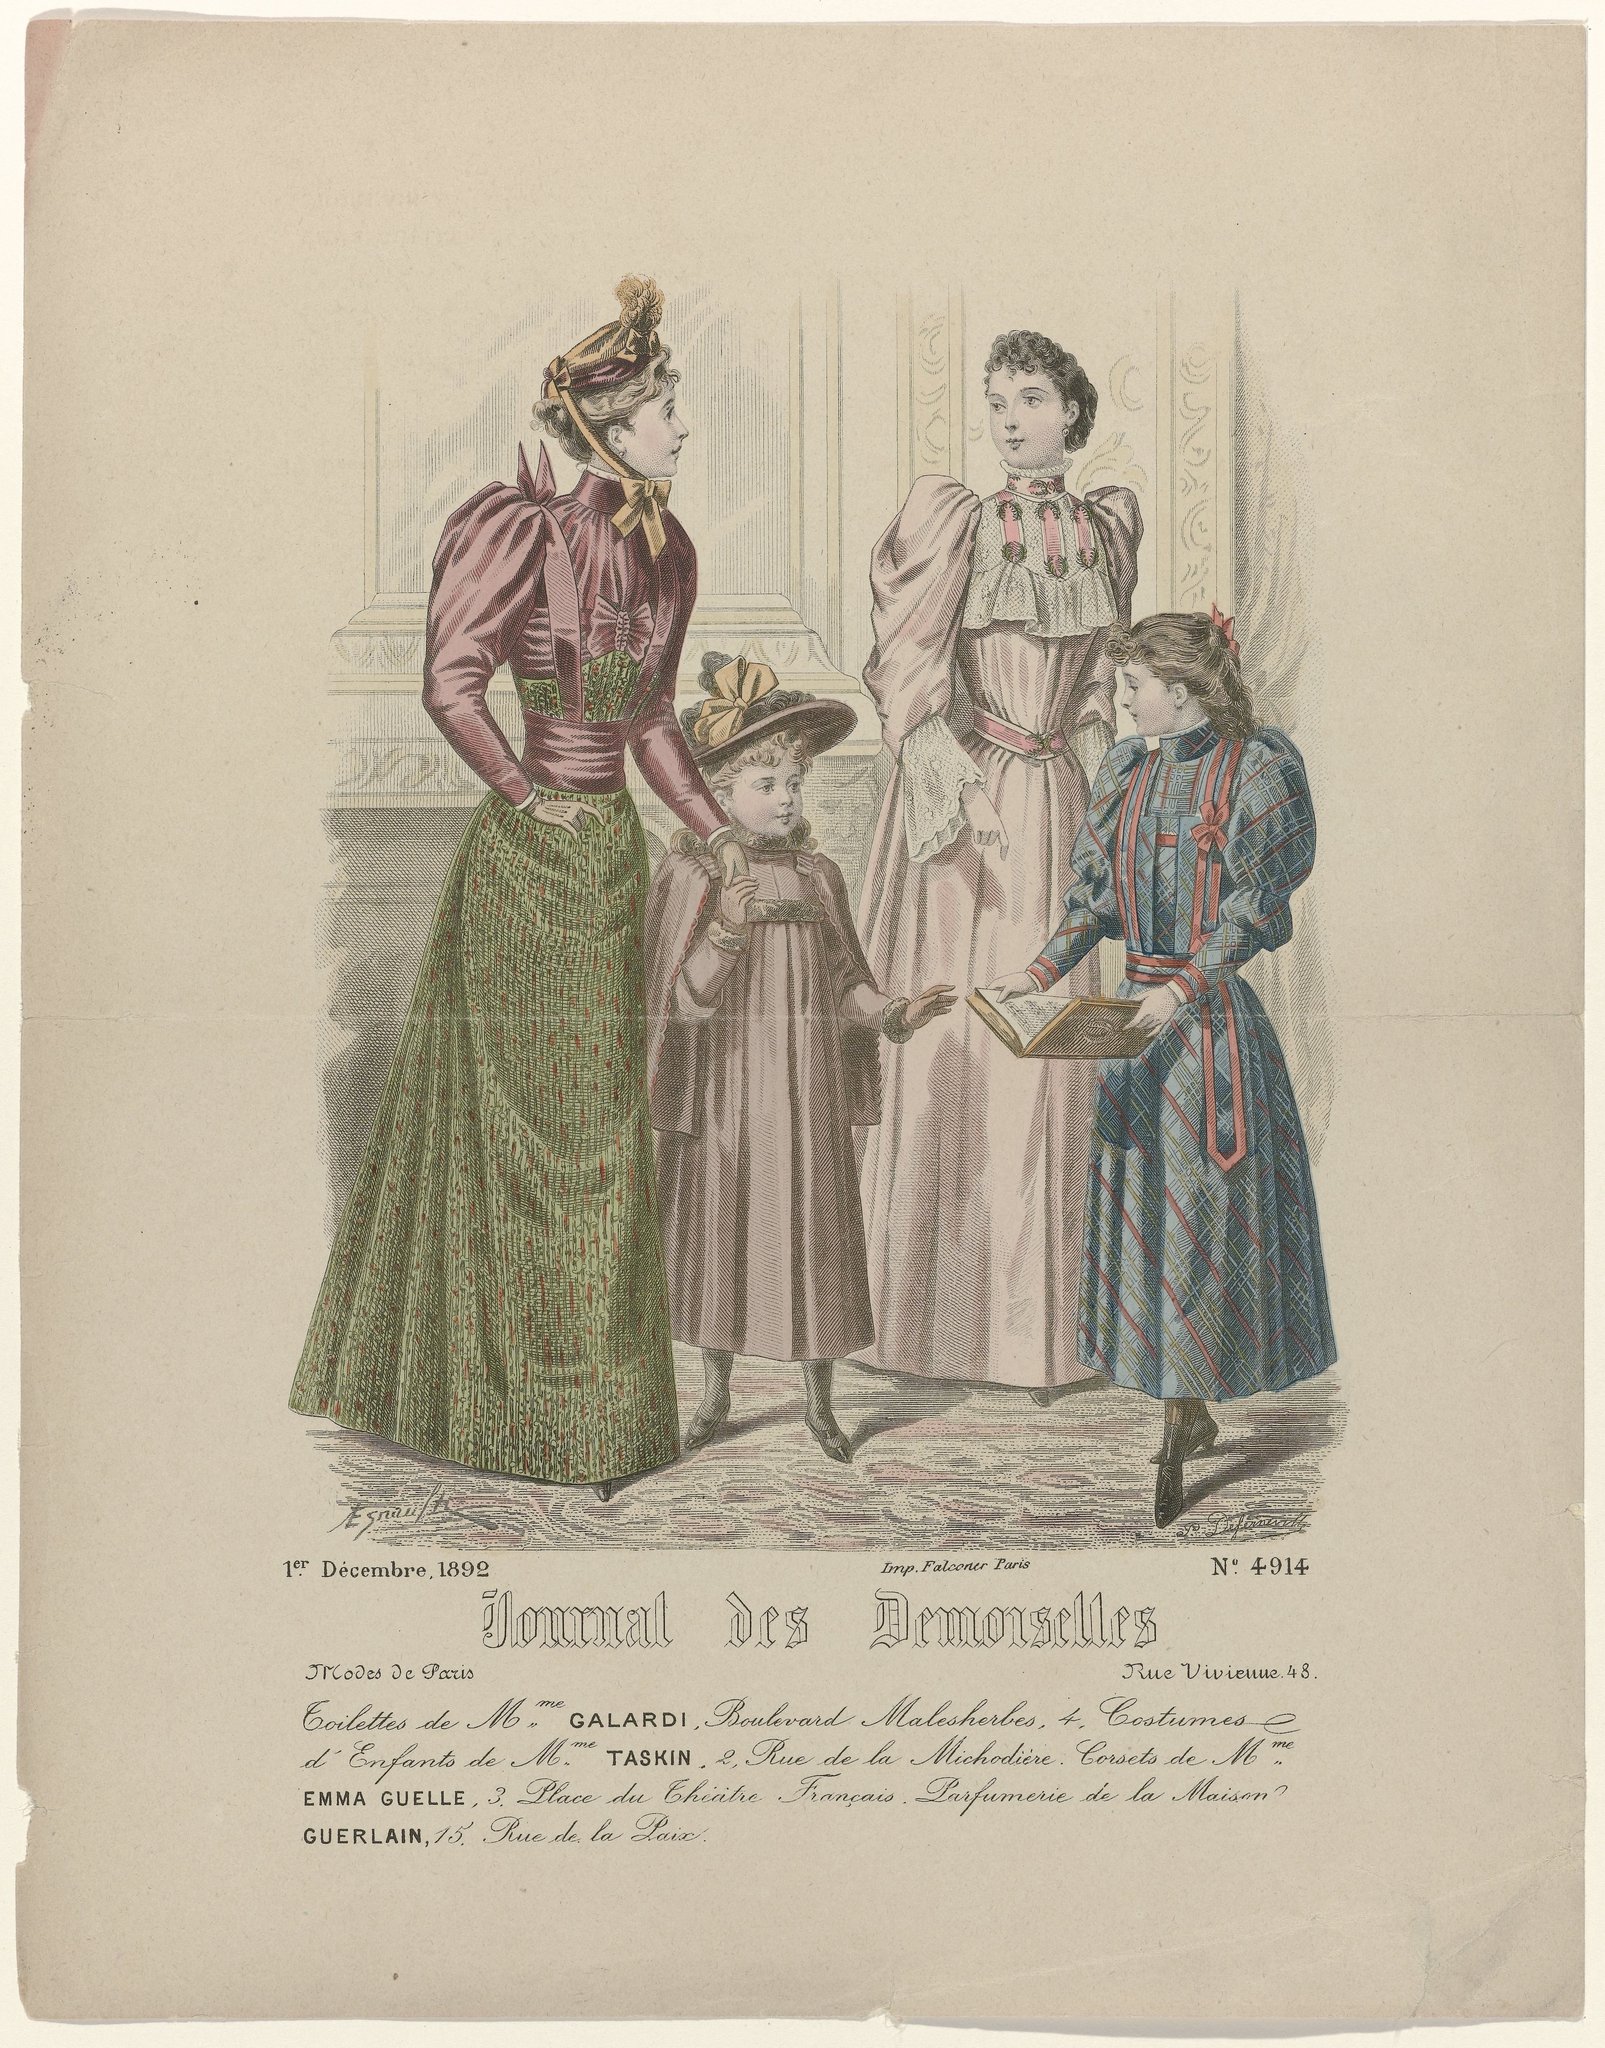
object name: fashion print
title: Journal des Demoiselles, 1 décembre 1892, No. 4914 : Toilettes de Mme Galard (...)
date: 1892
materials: paper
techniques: engraving, hand coloring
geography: paris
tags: head-gear (+ girls' clothes), shoes, sandals (+ girls' clothes), fashion plates, head-gear: hat (+ women's clothes), gloves, mittens, etc. (+ women's clothes), dress, gown (+ women's clothes), book - mm - book open, dress, gown (+ girls' clothes)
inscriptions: caption: ‘Toilettes de M.me Galardi, Boulevard Malesherbes, 4, Costumes d'Enfants de M.me Taskin, r, Rue de la Michodière. Corsets de M.me Emma Guelle, r, Place du Théâtre Français. Parfumerie de la Maison Guerlain,15, Rue de la Paix.’, title: ‘Journal des Demoiselles’, address: ‘Modes de Paris / Rue Vivienne, 48.’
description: Twee vrouwen en twee meisjes in een interieur. Volgens het onderschrift: 'toilettes' van Galardi. Kinderkleding van Taskin. Hieronder enkele regels reclametekst voor verschillende producten. Prent uit het modetijdschrift Journal des Demoiselles (1833 -1922).